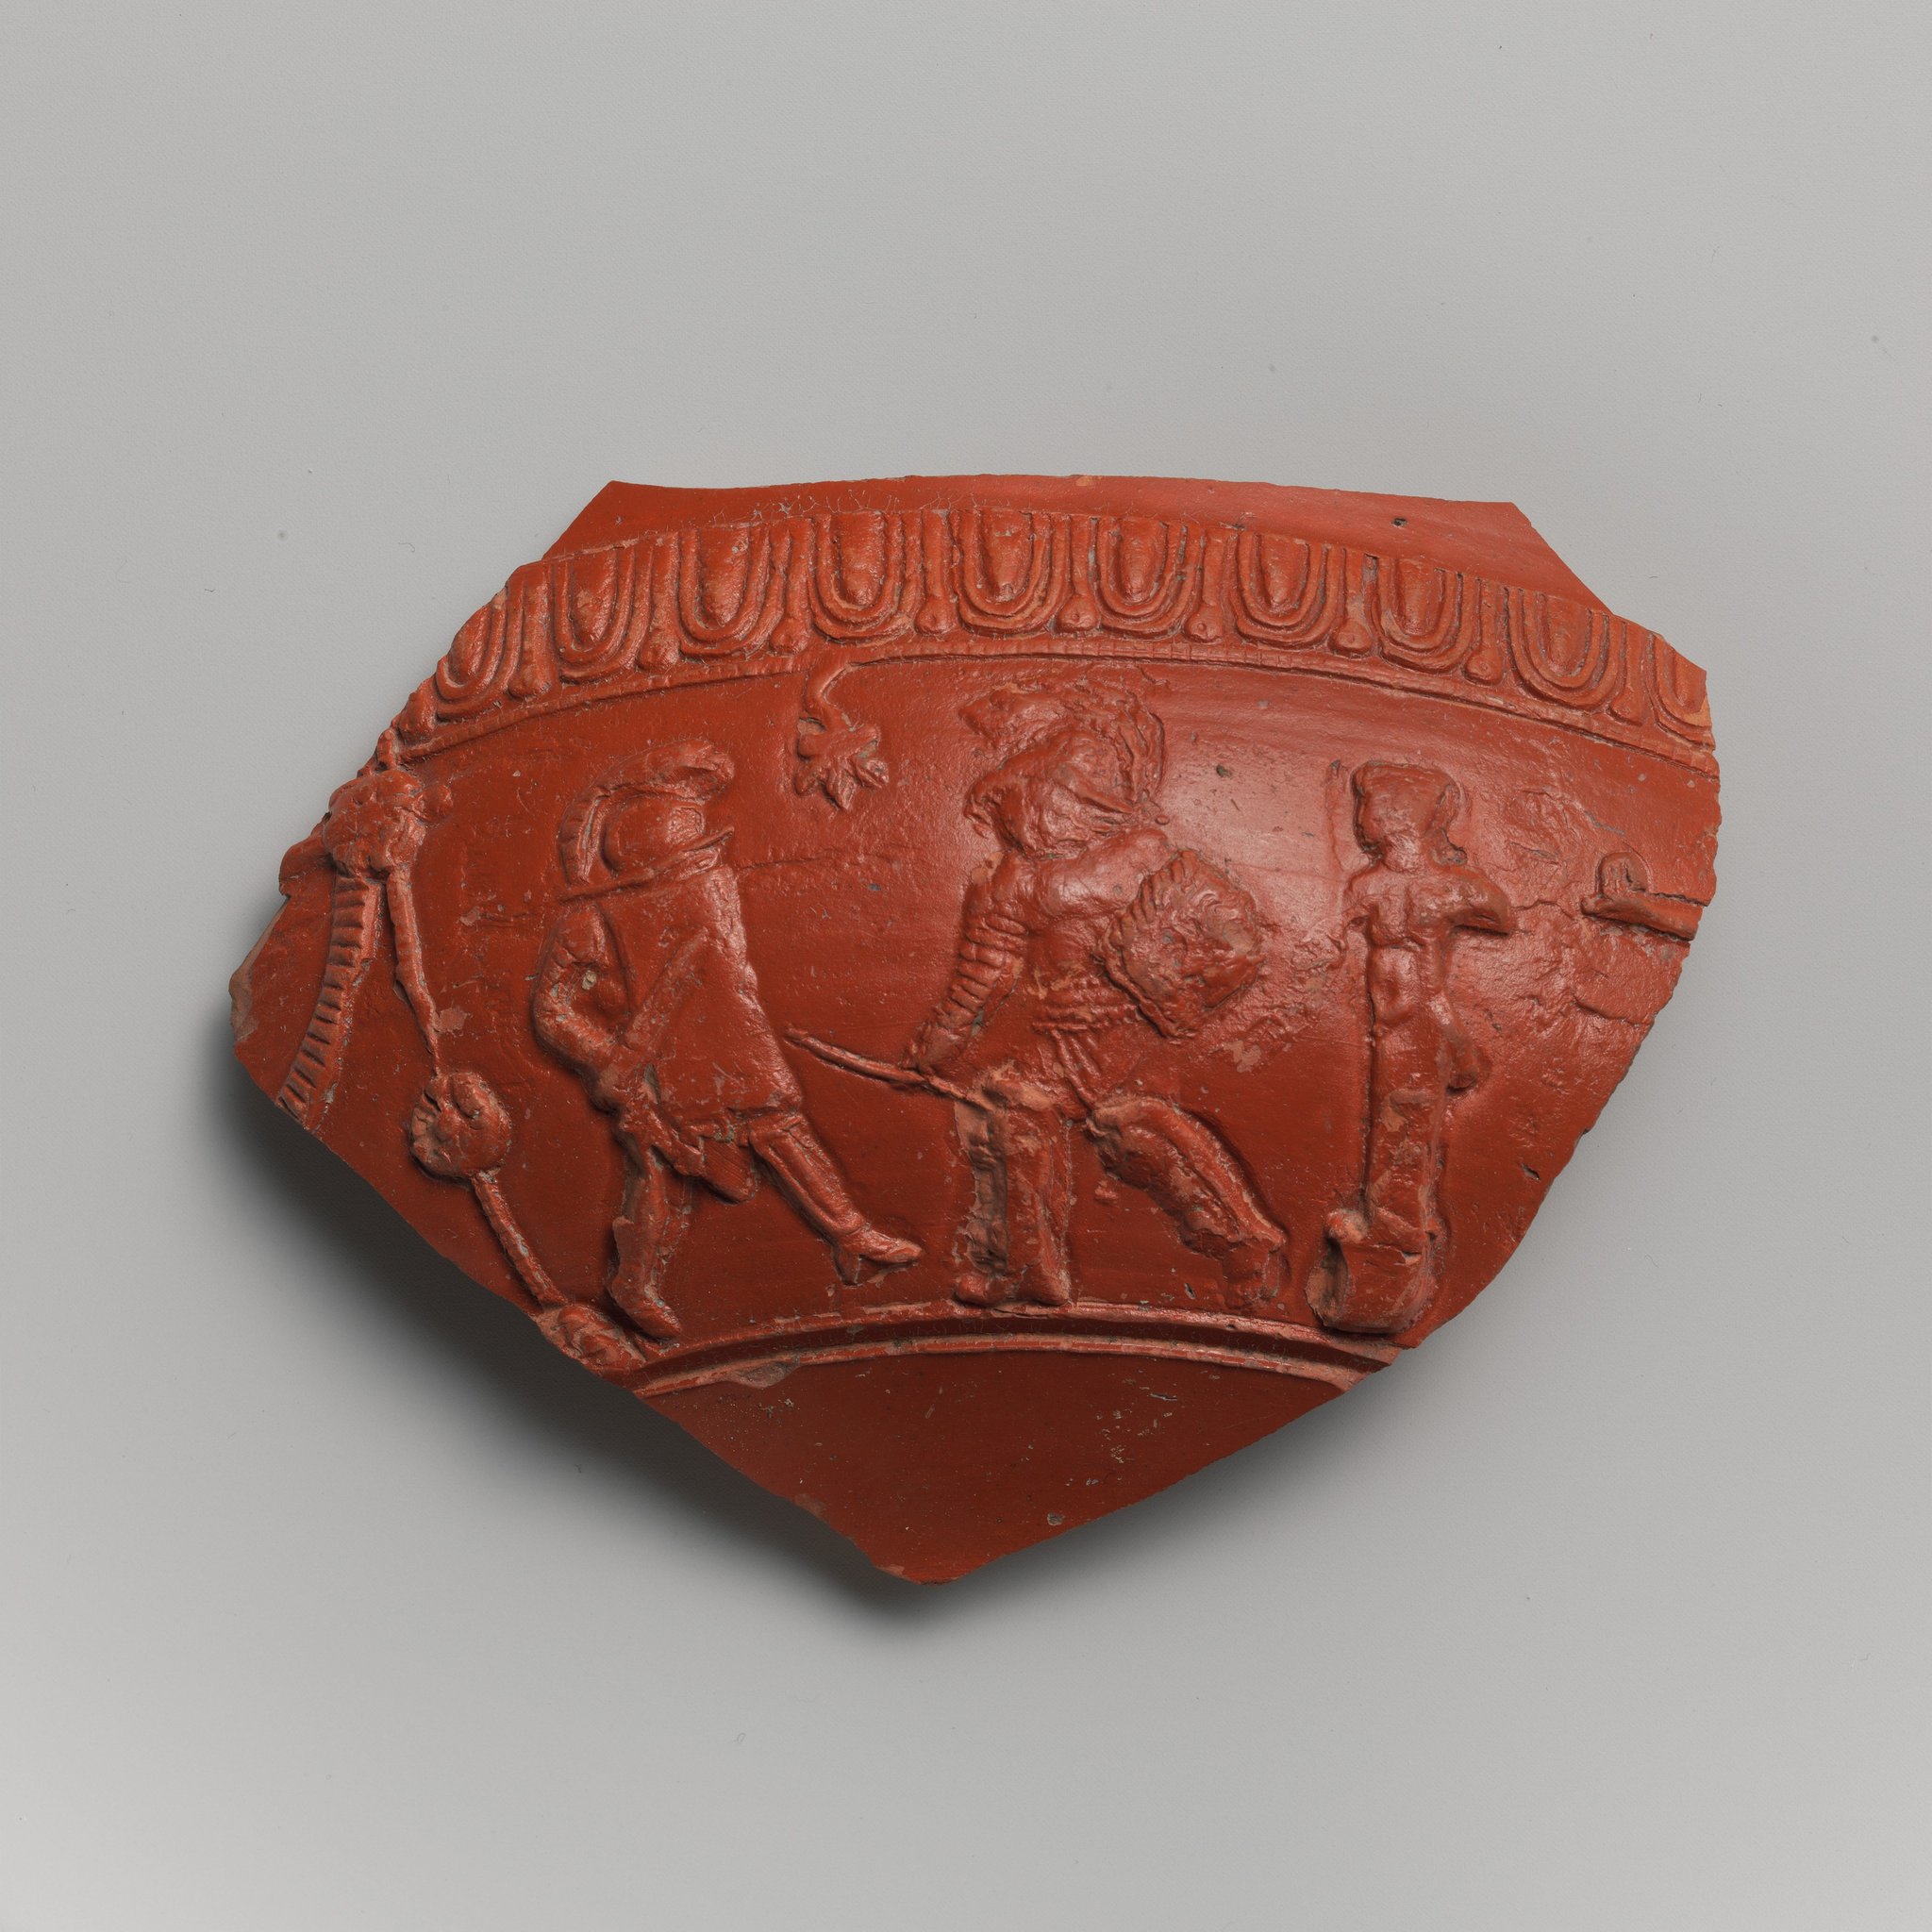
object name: vase fragment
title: Terracotta fragment of a bowl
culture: roman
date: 134-166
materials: terracotta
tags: battles,soldiers